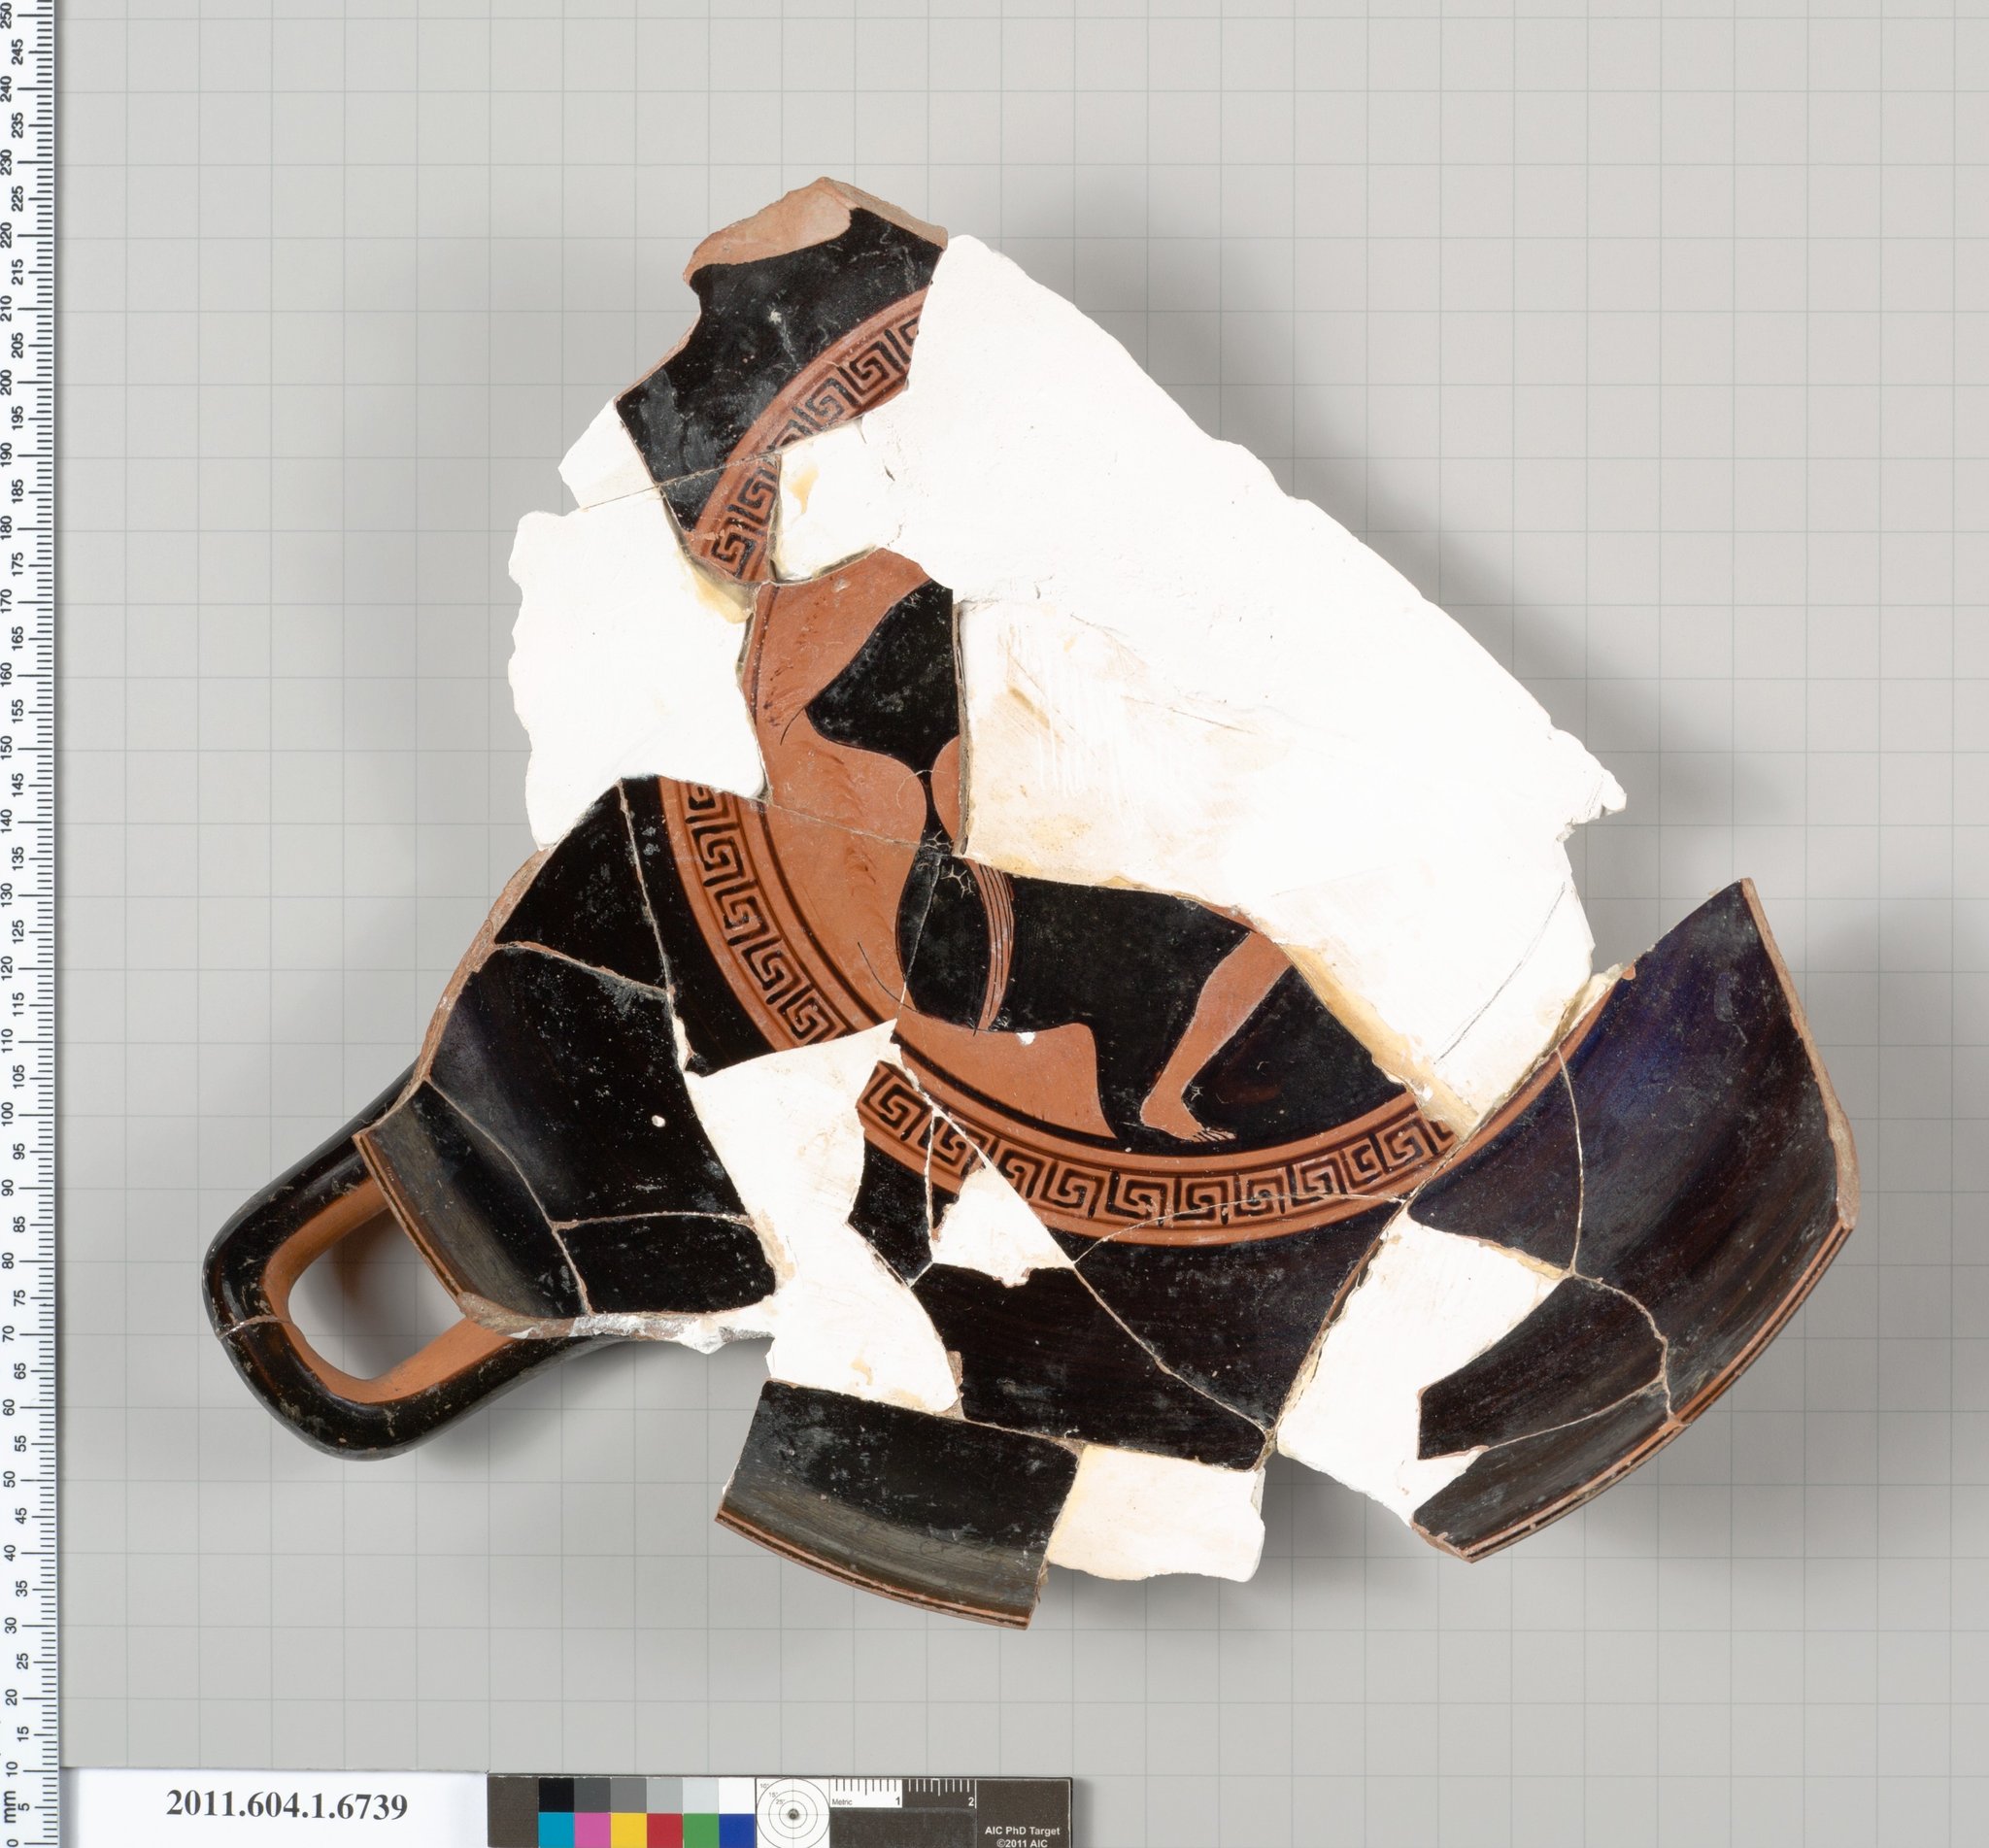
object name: kylix fragment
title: Terracotta fragment of a kylix (drinking cup)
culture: greek, attic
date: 490-470 BCE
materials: terracotta